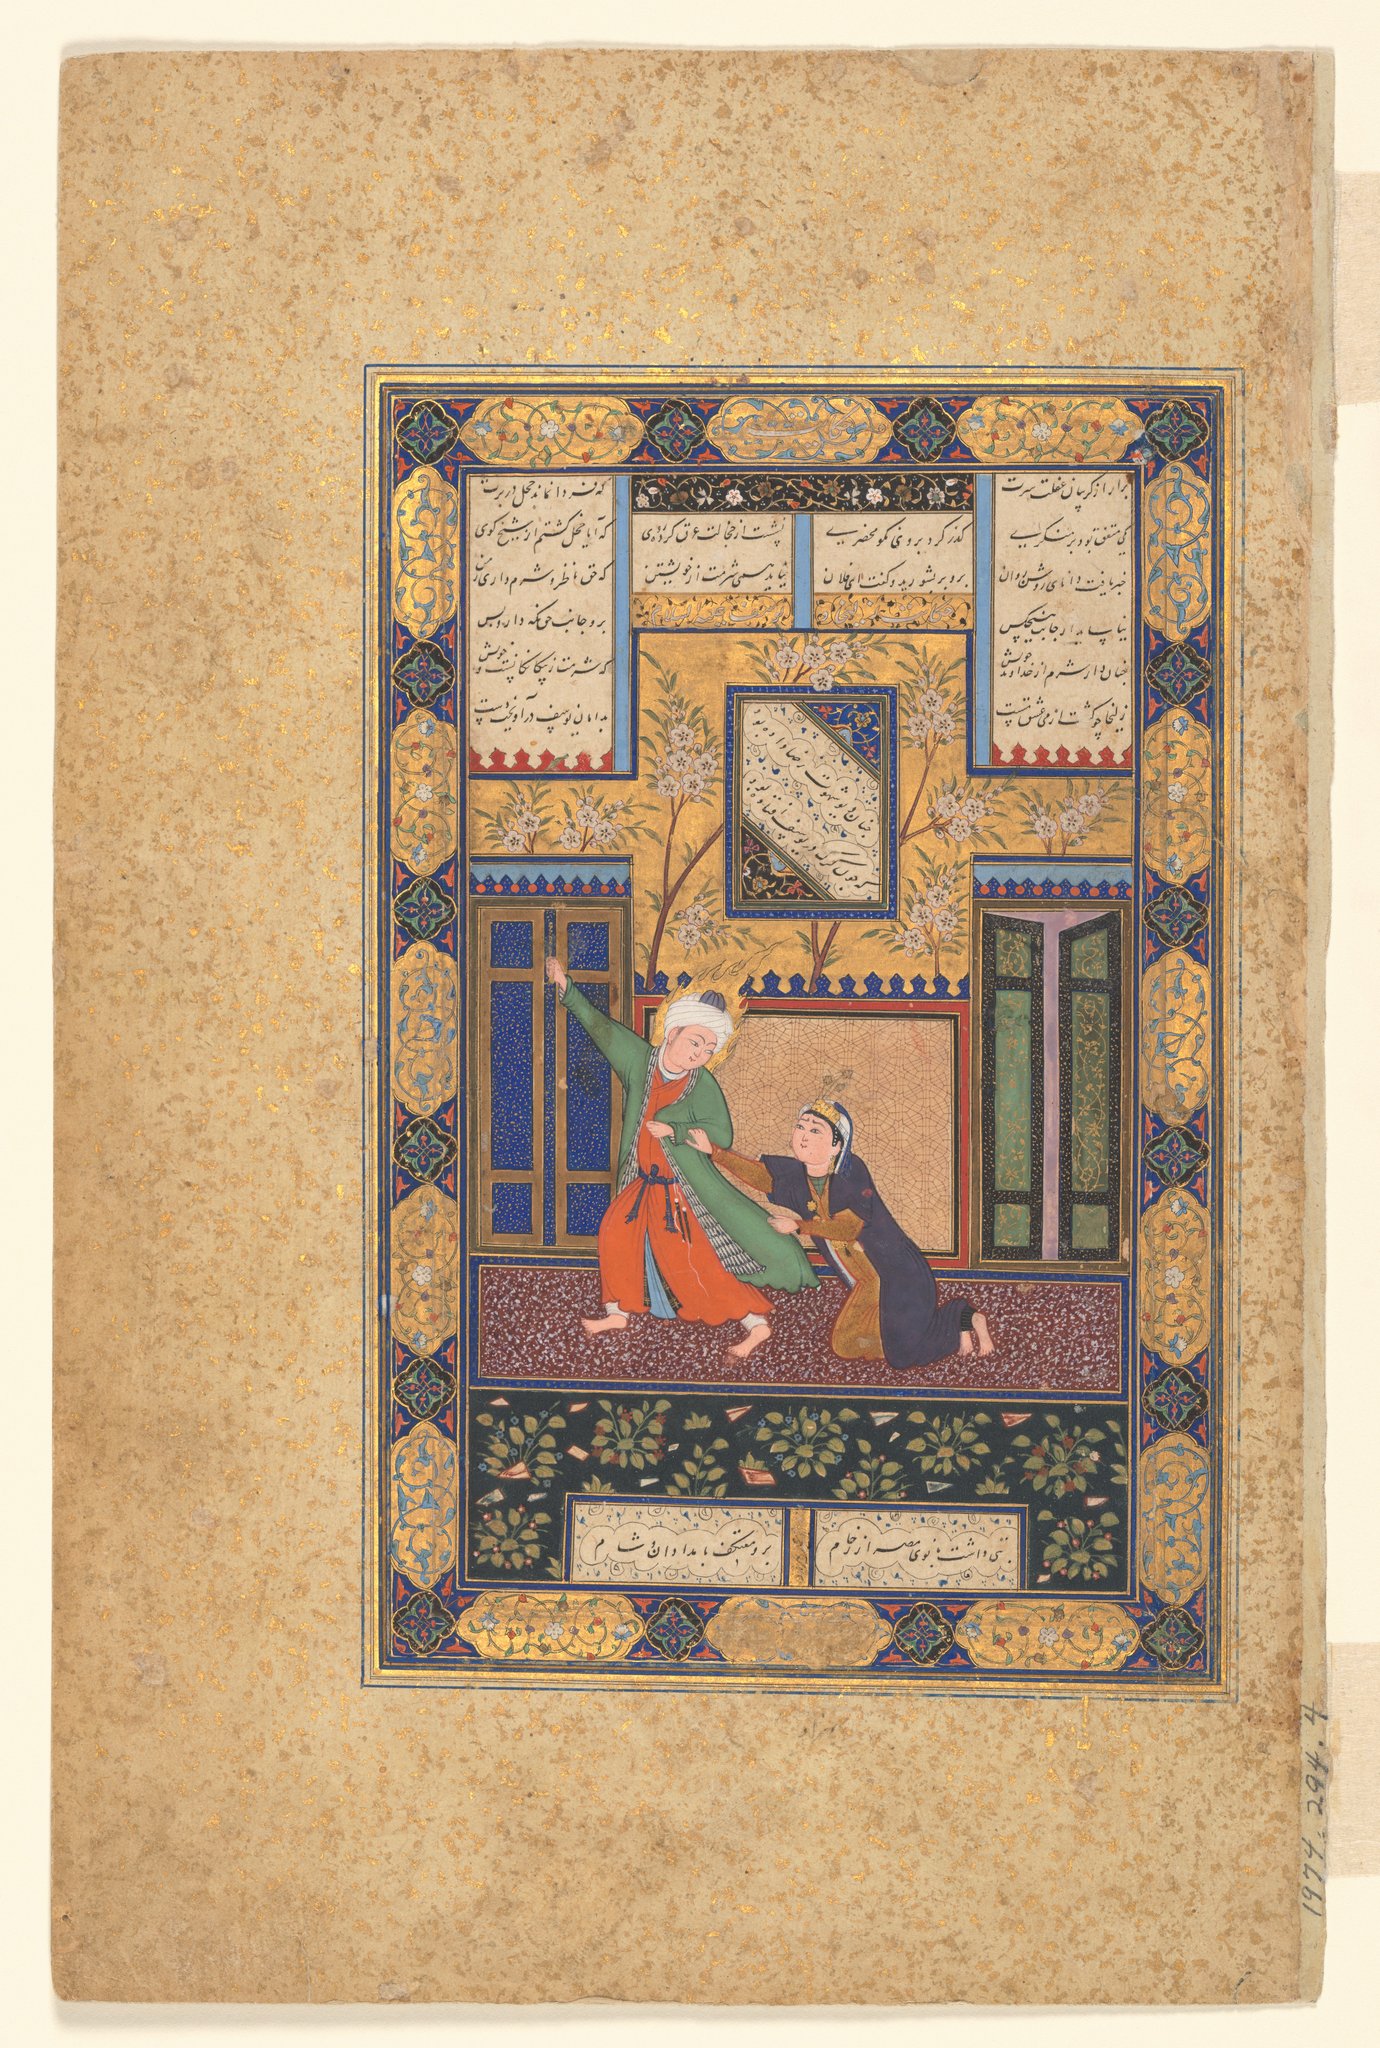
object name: folio from an illustrated manuscript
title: "Yusuf and Zulaikha", Folio 51r from a Bustan of Sa`di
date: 1525-1535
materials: gold, ink, paper, watercolor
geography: uzbekistan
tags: men,women